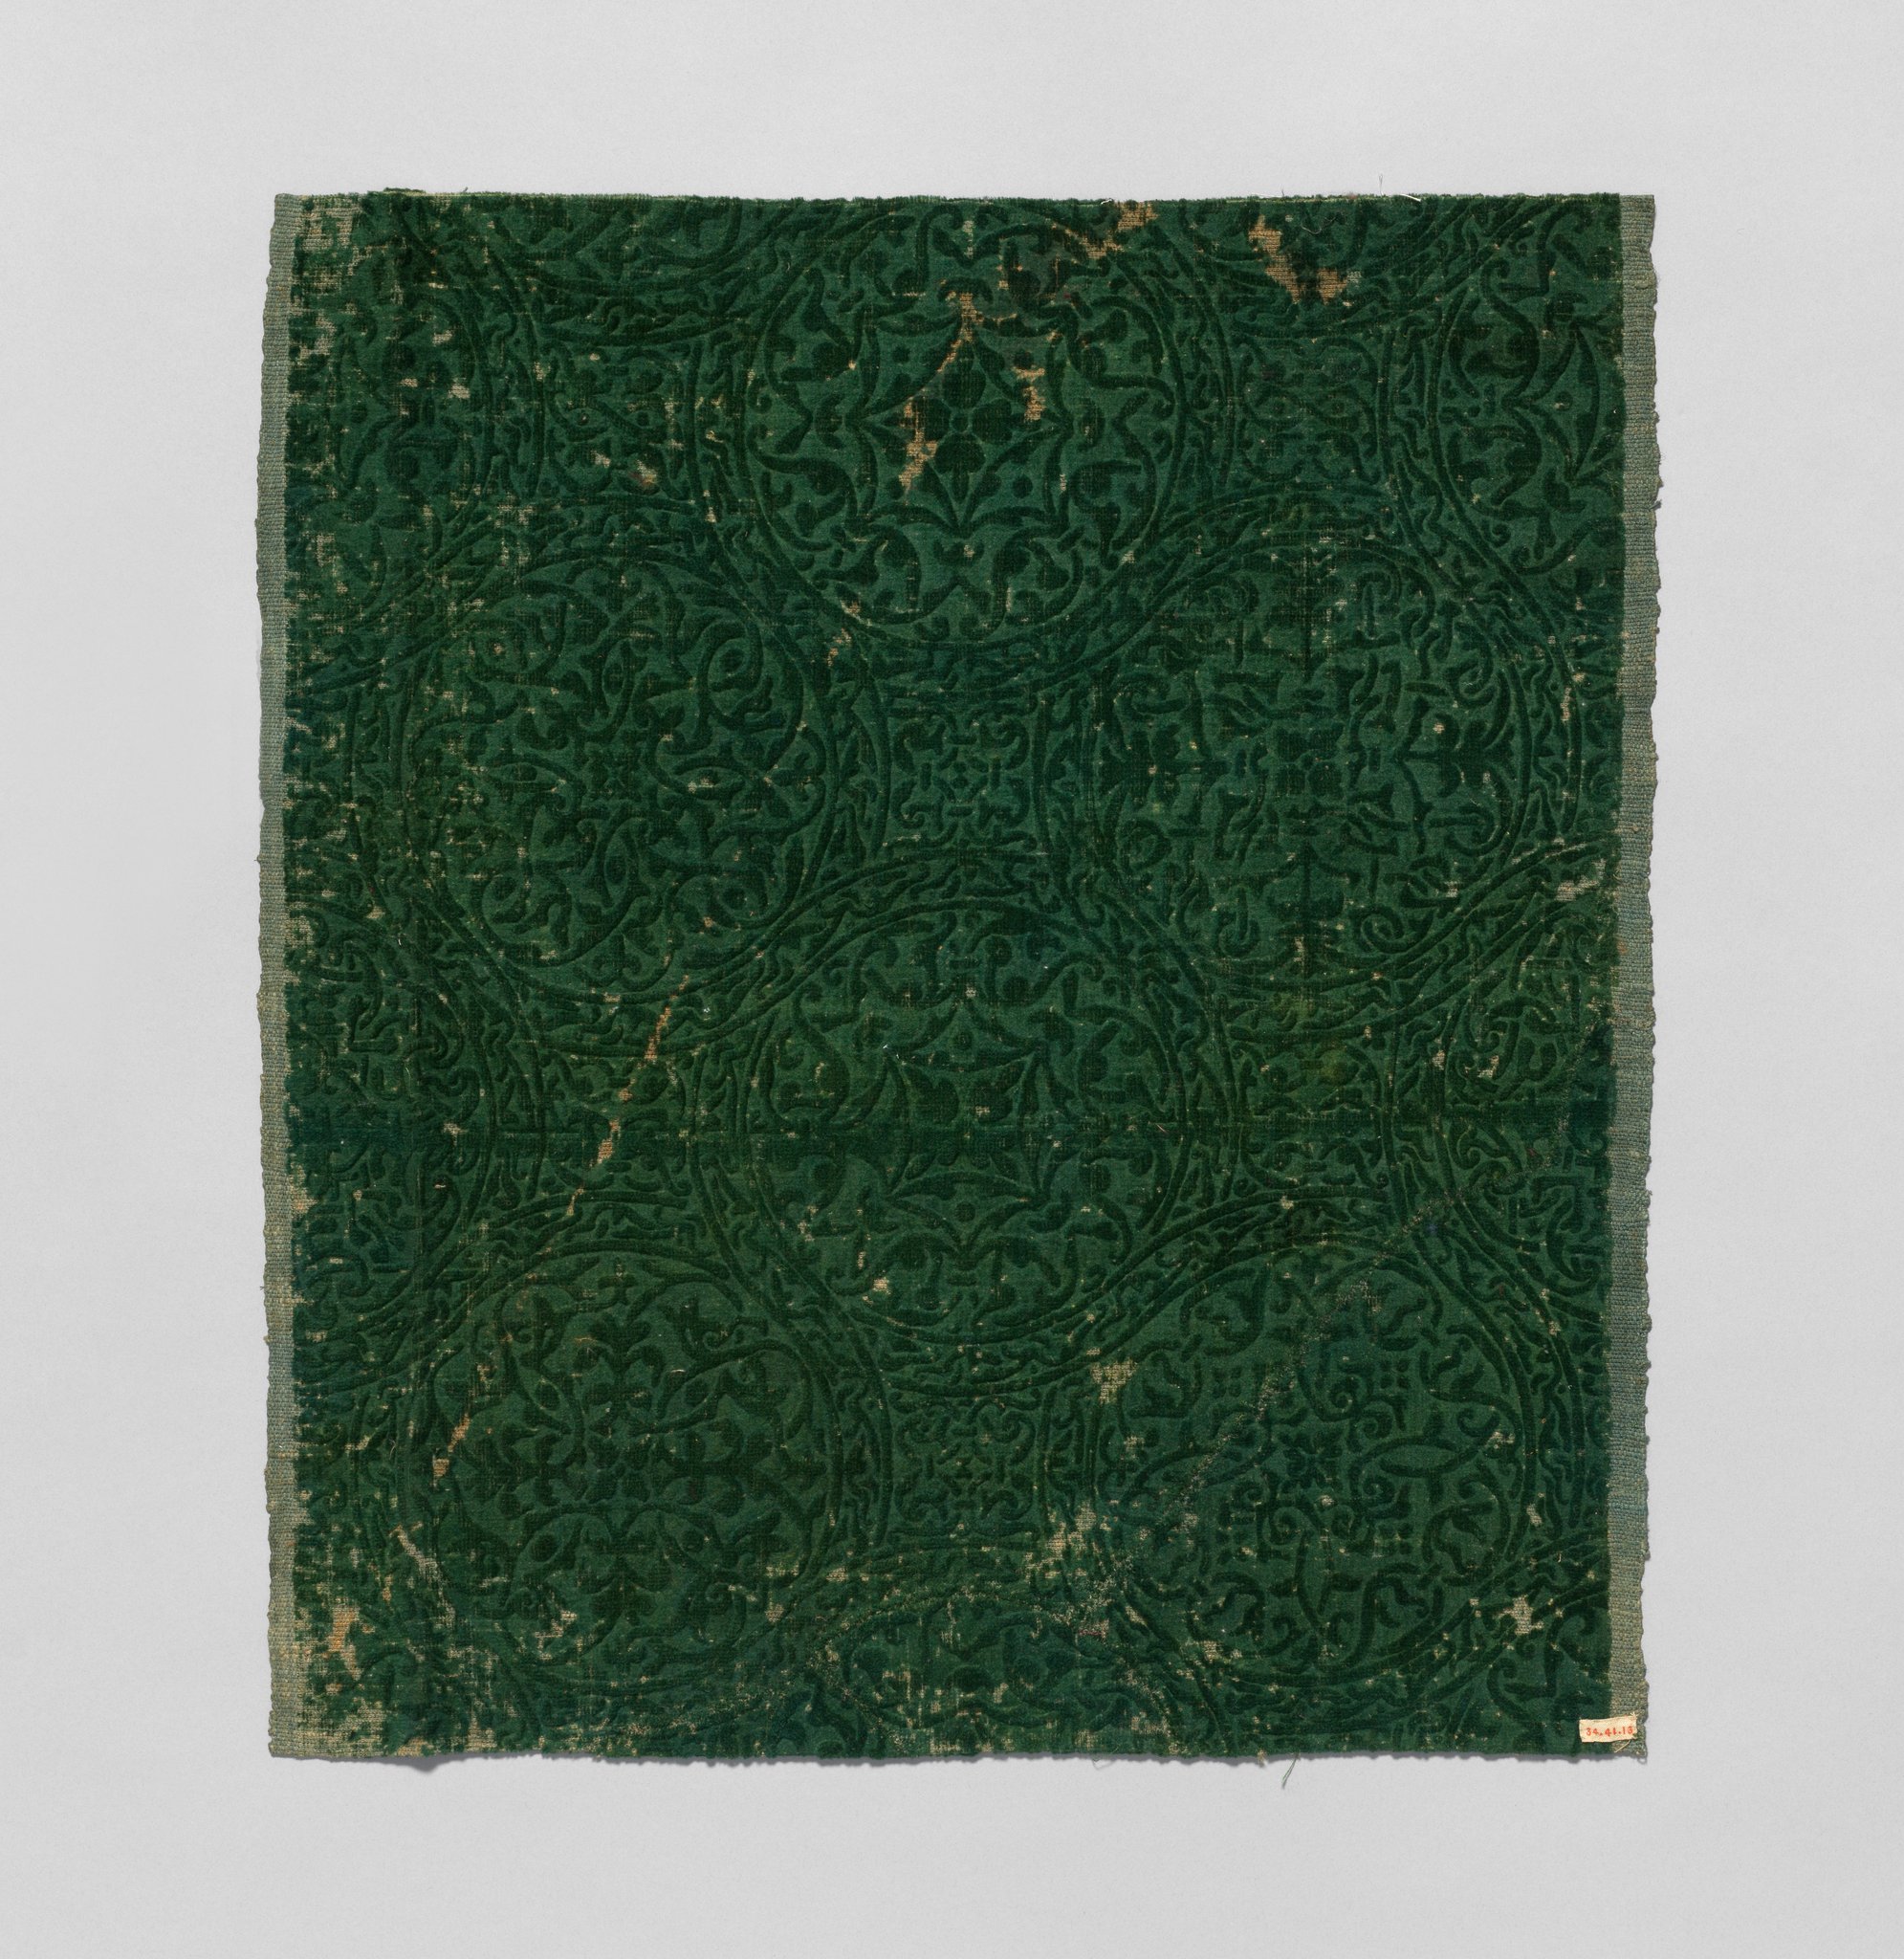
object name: piece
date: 1501-1600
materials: wool